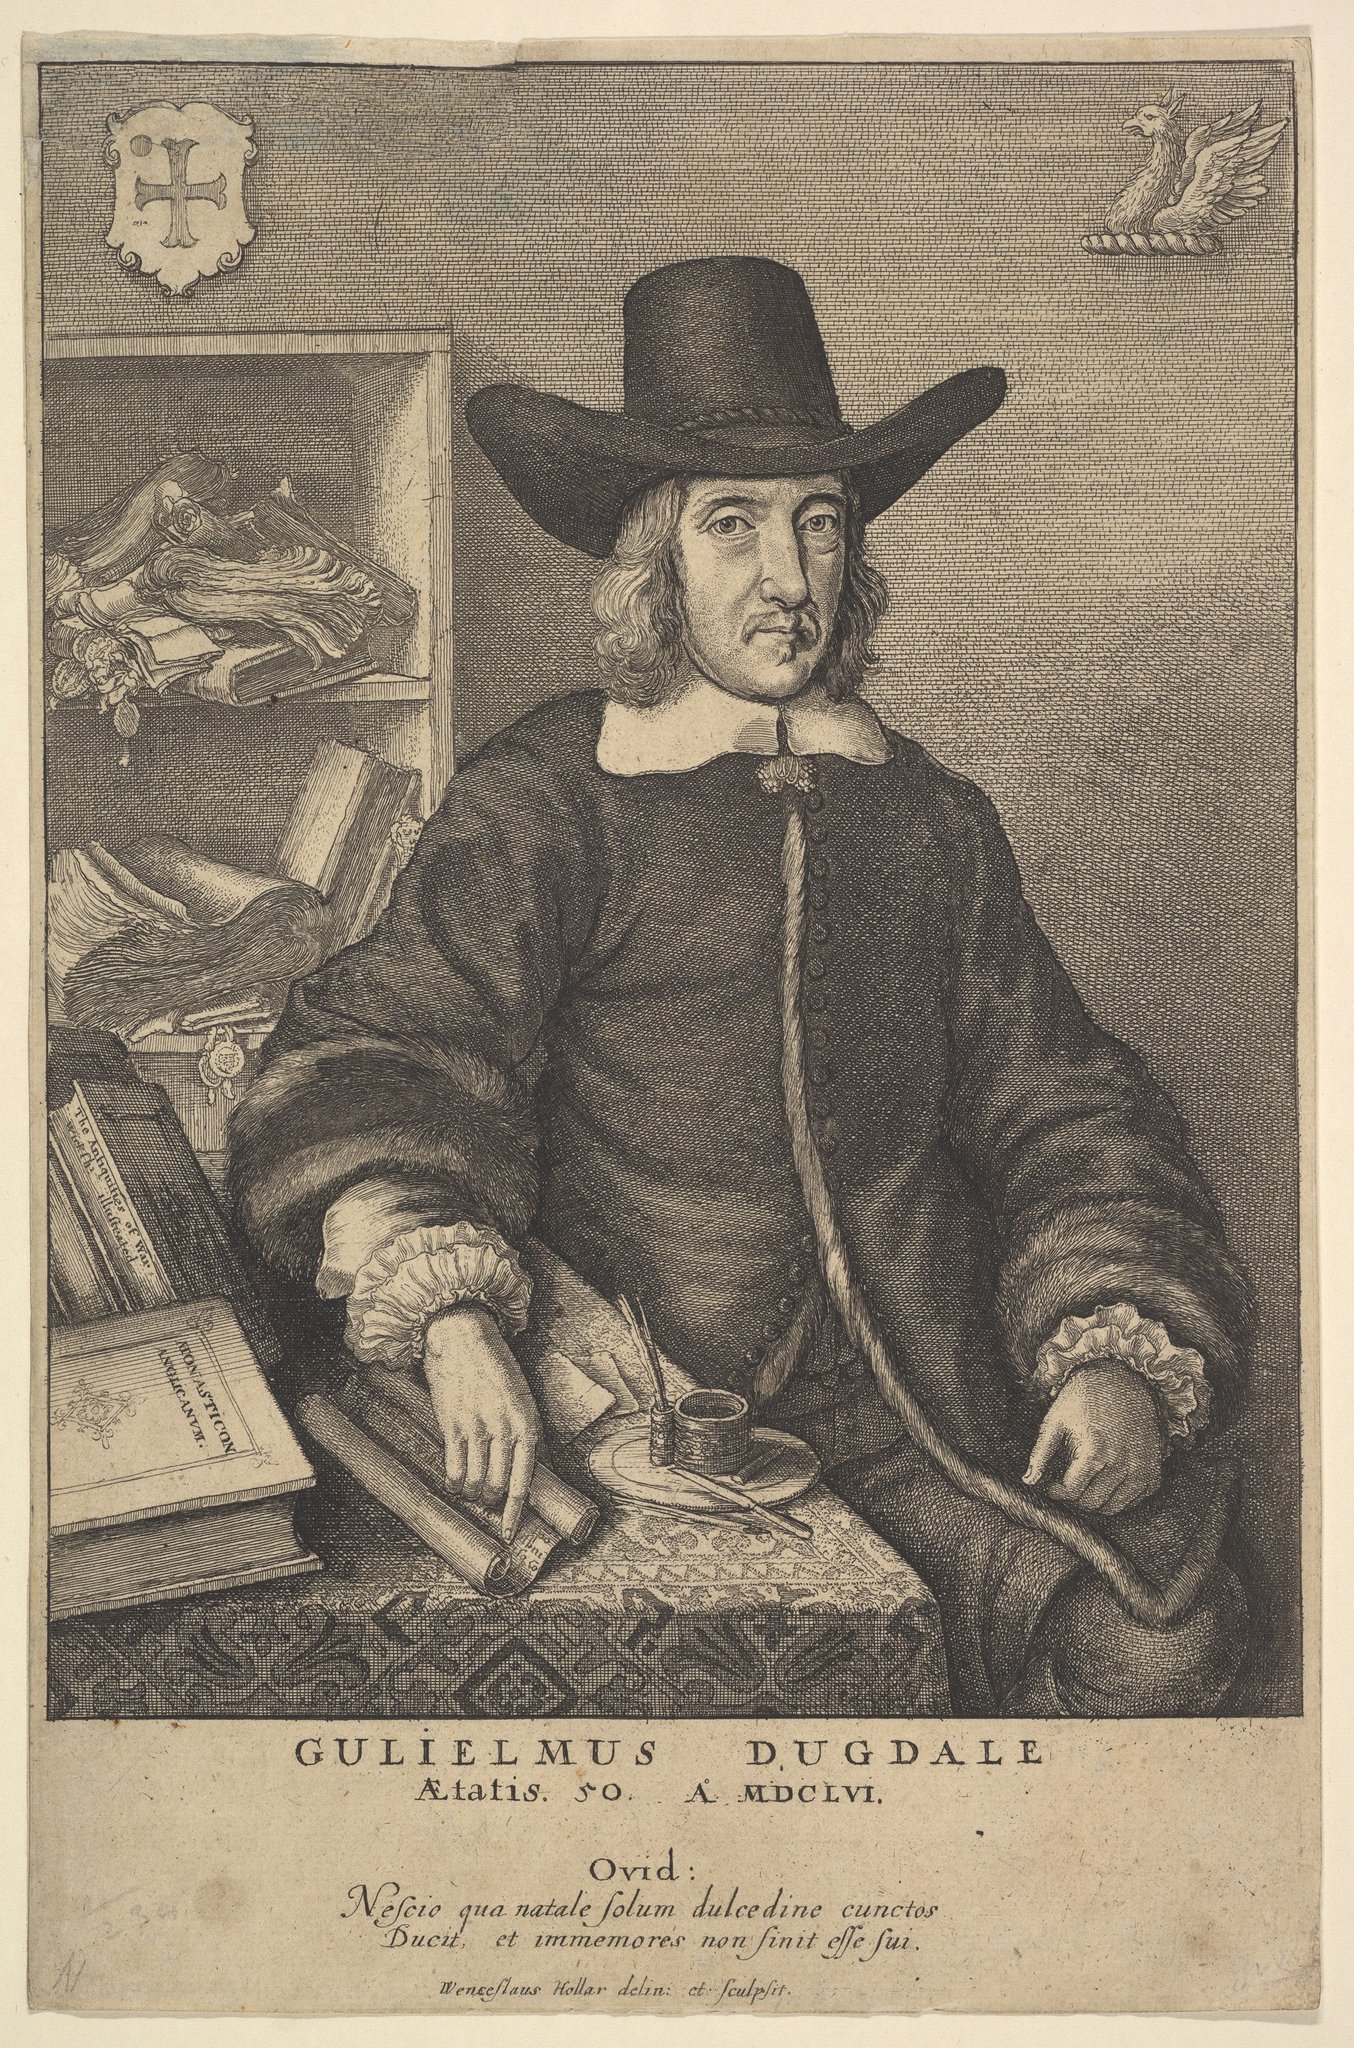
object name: print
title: William Dugdale (Gulielmus Dugdale) (from "The Antiquities of Warwickshire Illustrated," London, 1656)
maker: wenceslaus hollar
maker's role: artist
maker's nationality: bohemian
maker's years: 1607-1677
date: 1656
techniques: etching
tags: men,portraits